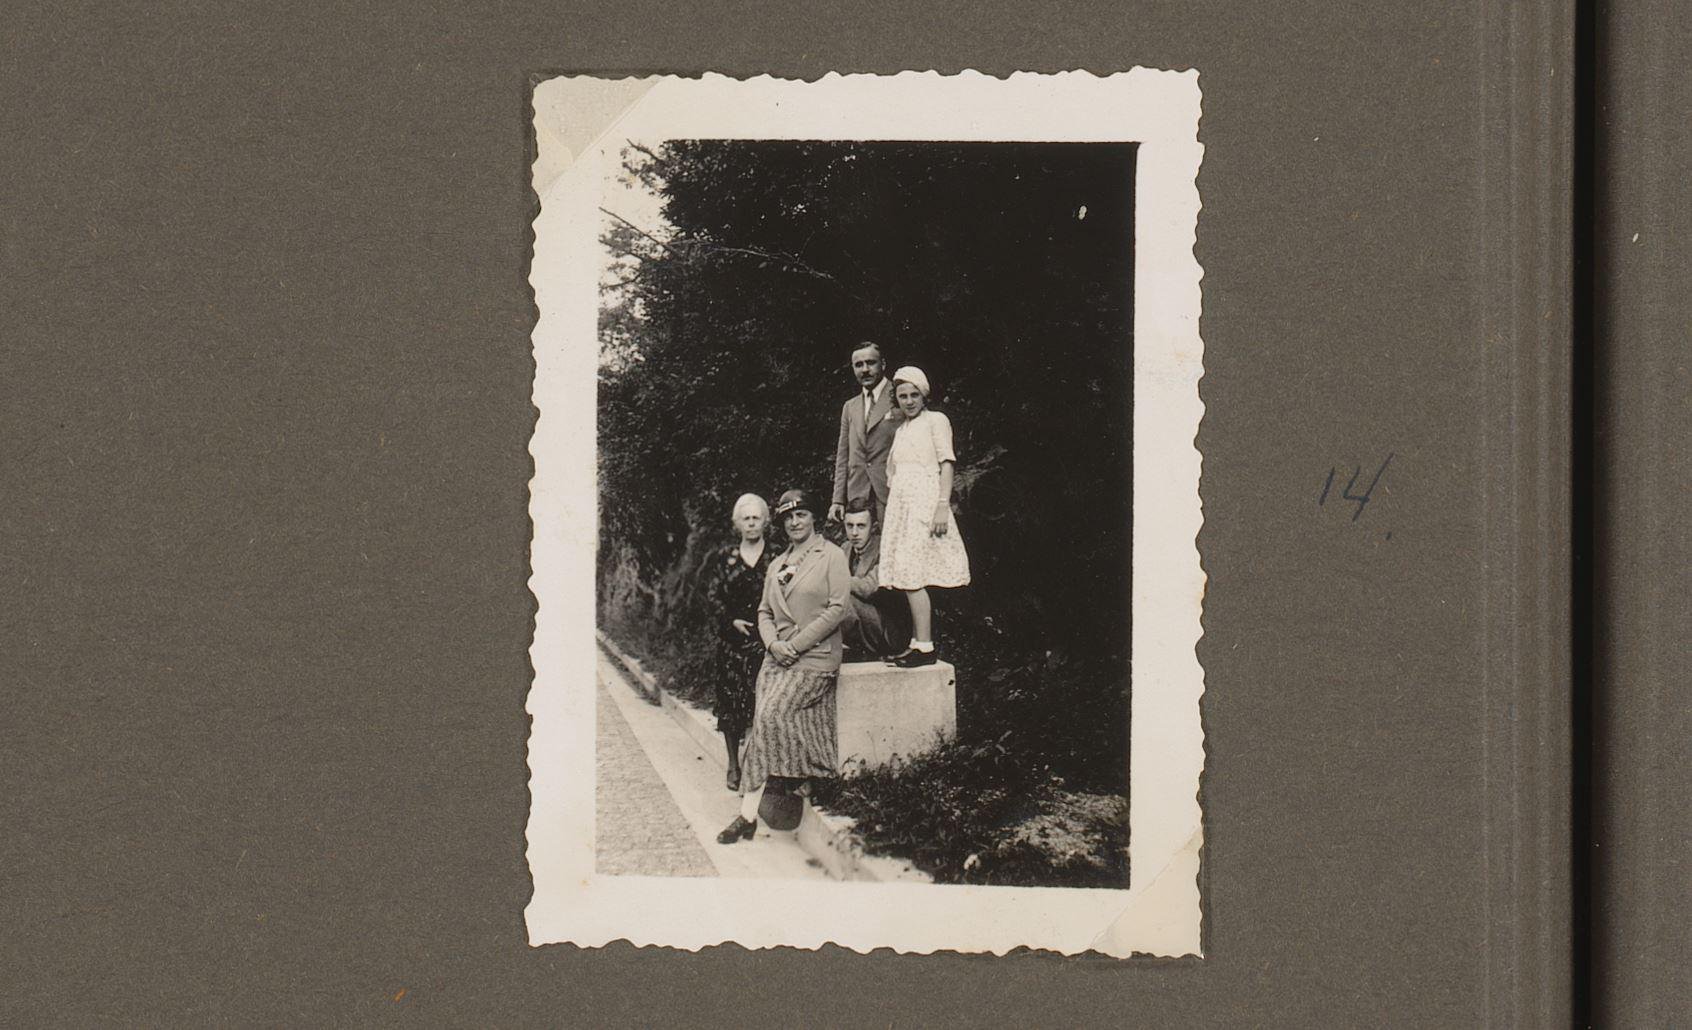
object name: album leaf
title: Gezelschap staande langs een weg in de buurt van de Monte Ceneri, Zwitserland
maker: Anonymous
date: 1934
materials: photographic support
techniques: gelatin silver print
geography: monte ceneri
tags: historical persons, loose company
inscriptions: number: ‘14’